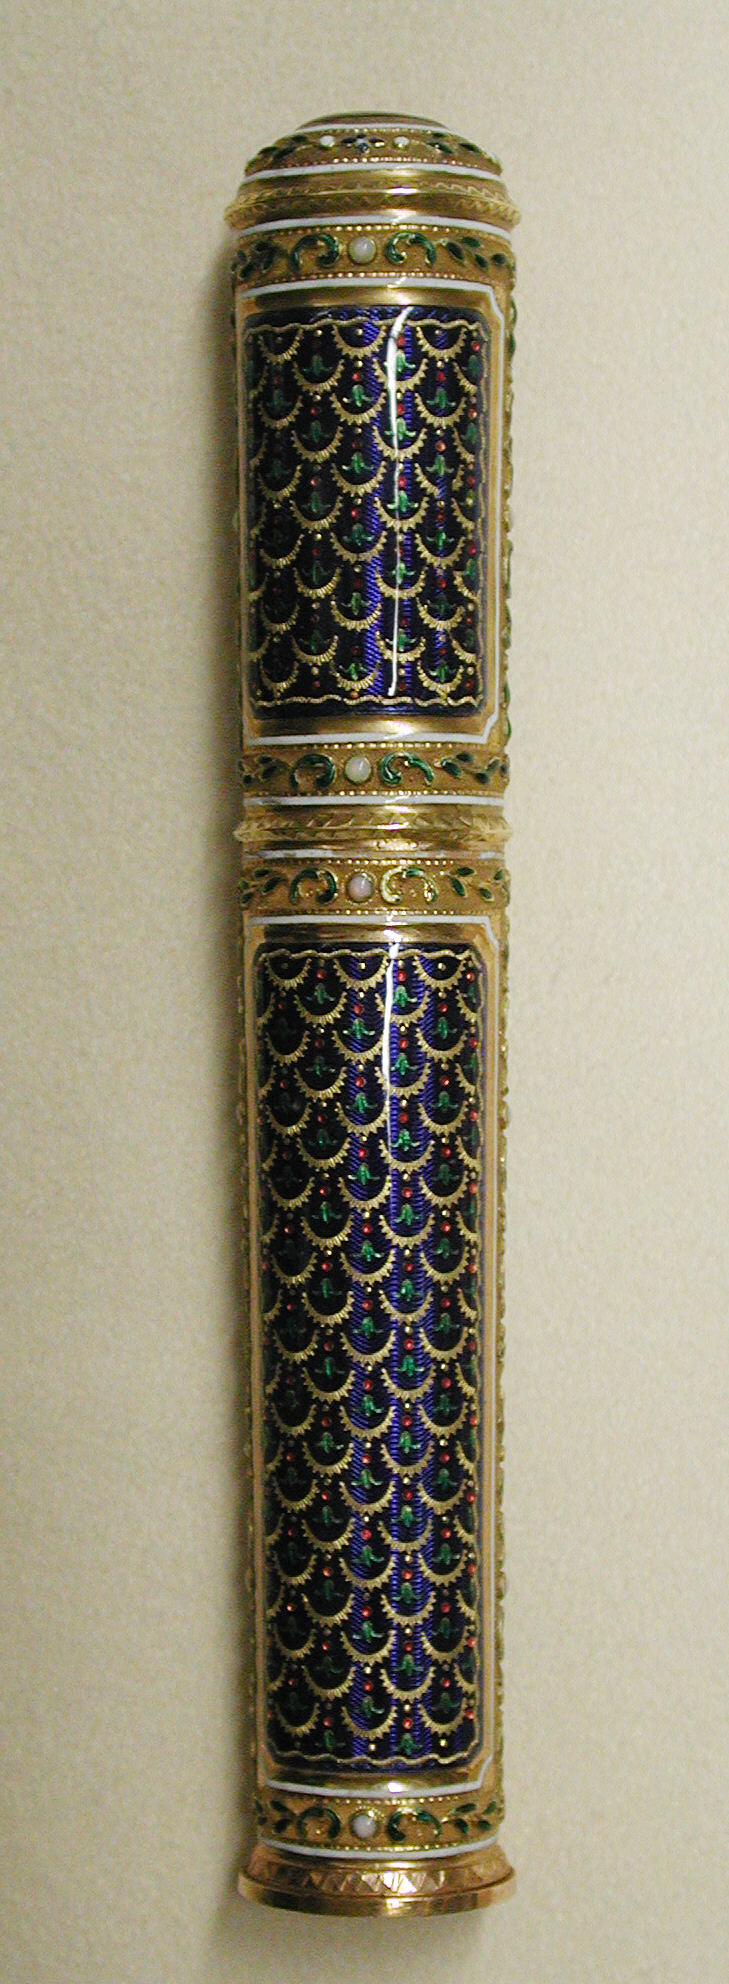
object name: étui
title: Sealing wax case (étui)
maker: georges-antoine croze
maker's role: maker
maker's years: 1777-1790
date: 1785-1786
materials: enamel, gold